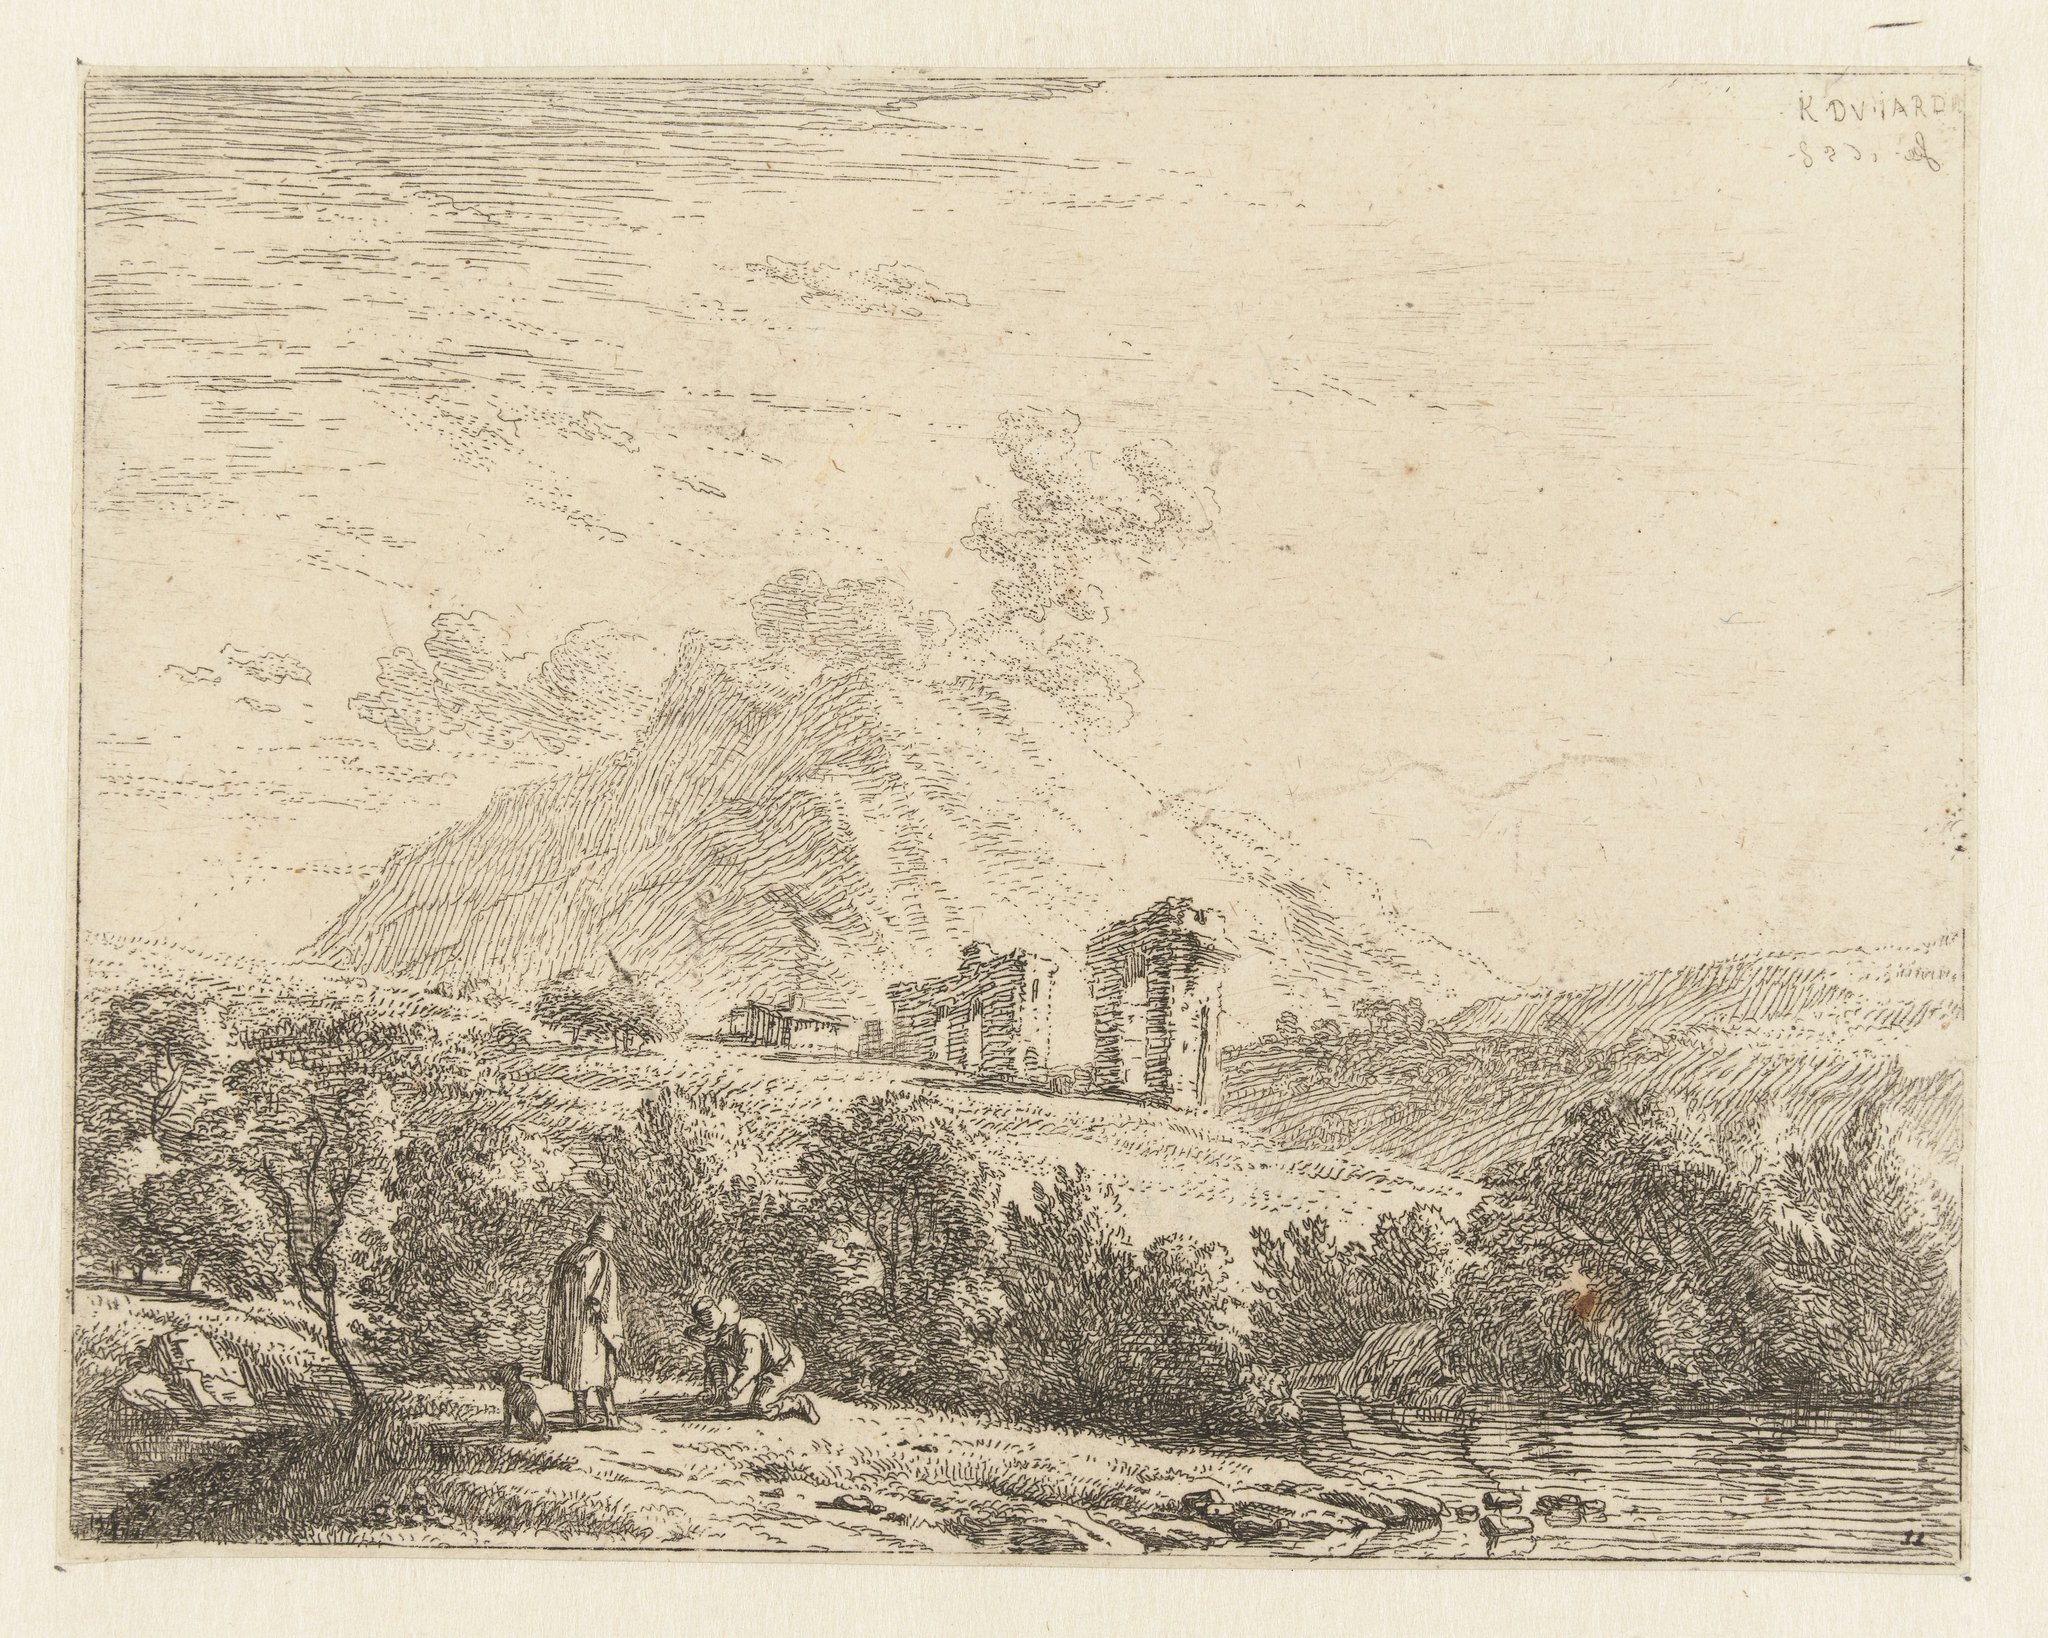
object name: print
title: Landschap met ruïne en twee mannen met een hond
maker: karel du jardin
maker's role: draughtsman, painter, print maker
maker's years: 1626-1678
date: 1658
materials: paper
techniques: etching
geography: the hague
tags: landscape with ruins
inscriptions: collector's mark: Lugt 2228a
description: Hollstein nrs. 9-12 lijken deel uit te maken van een serie.